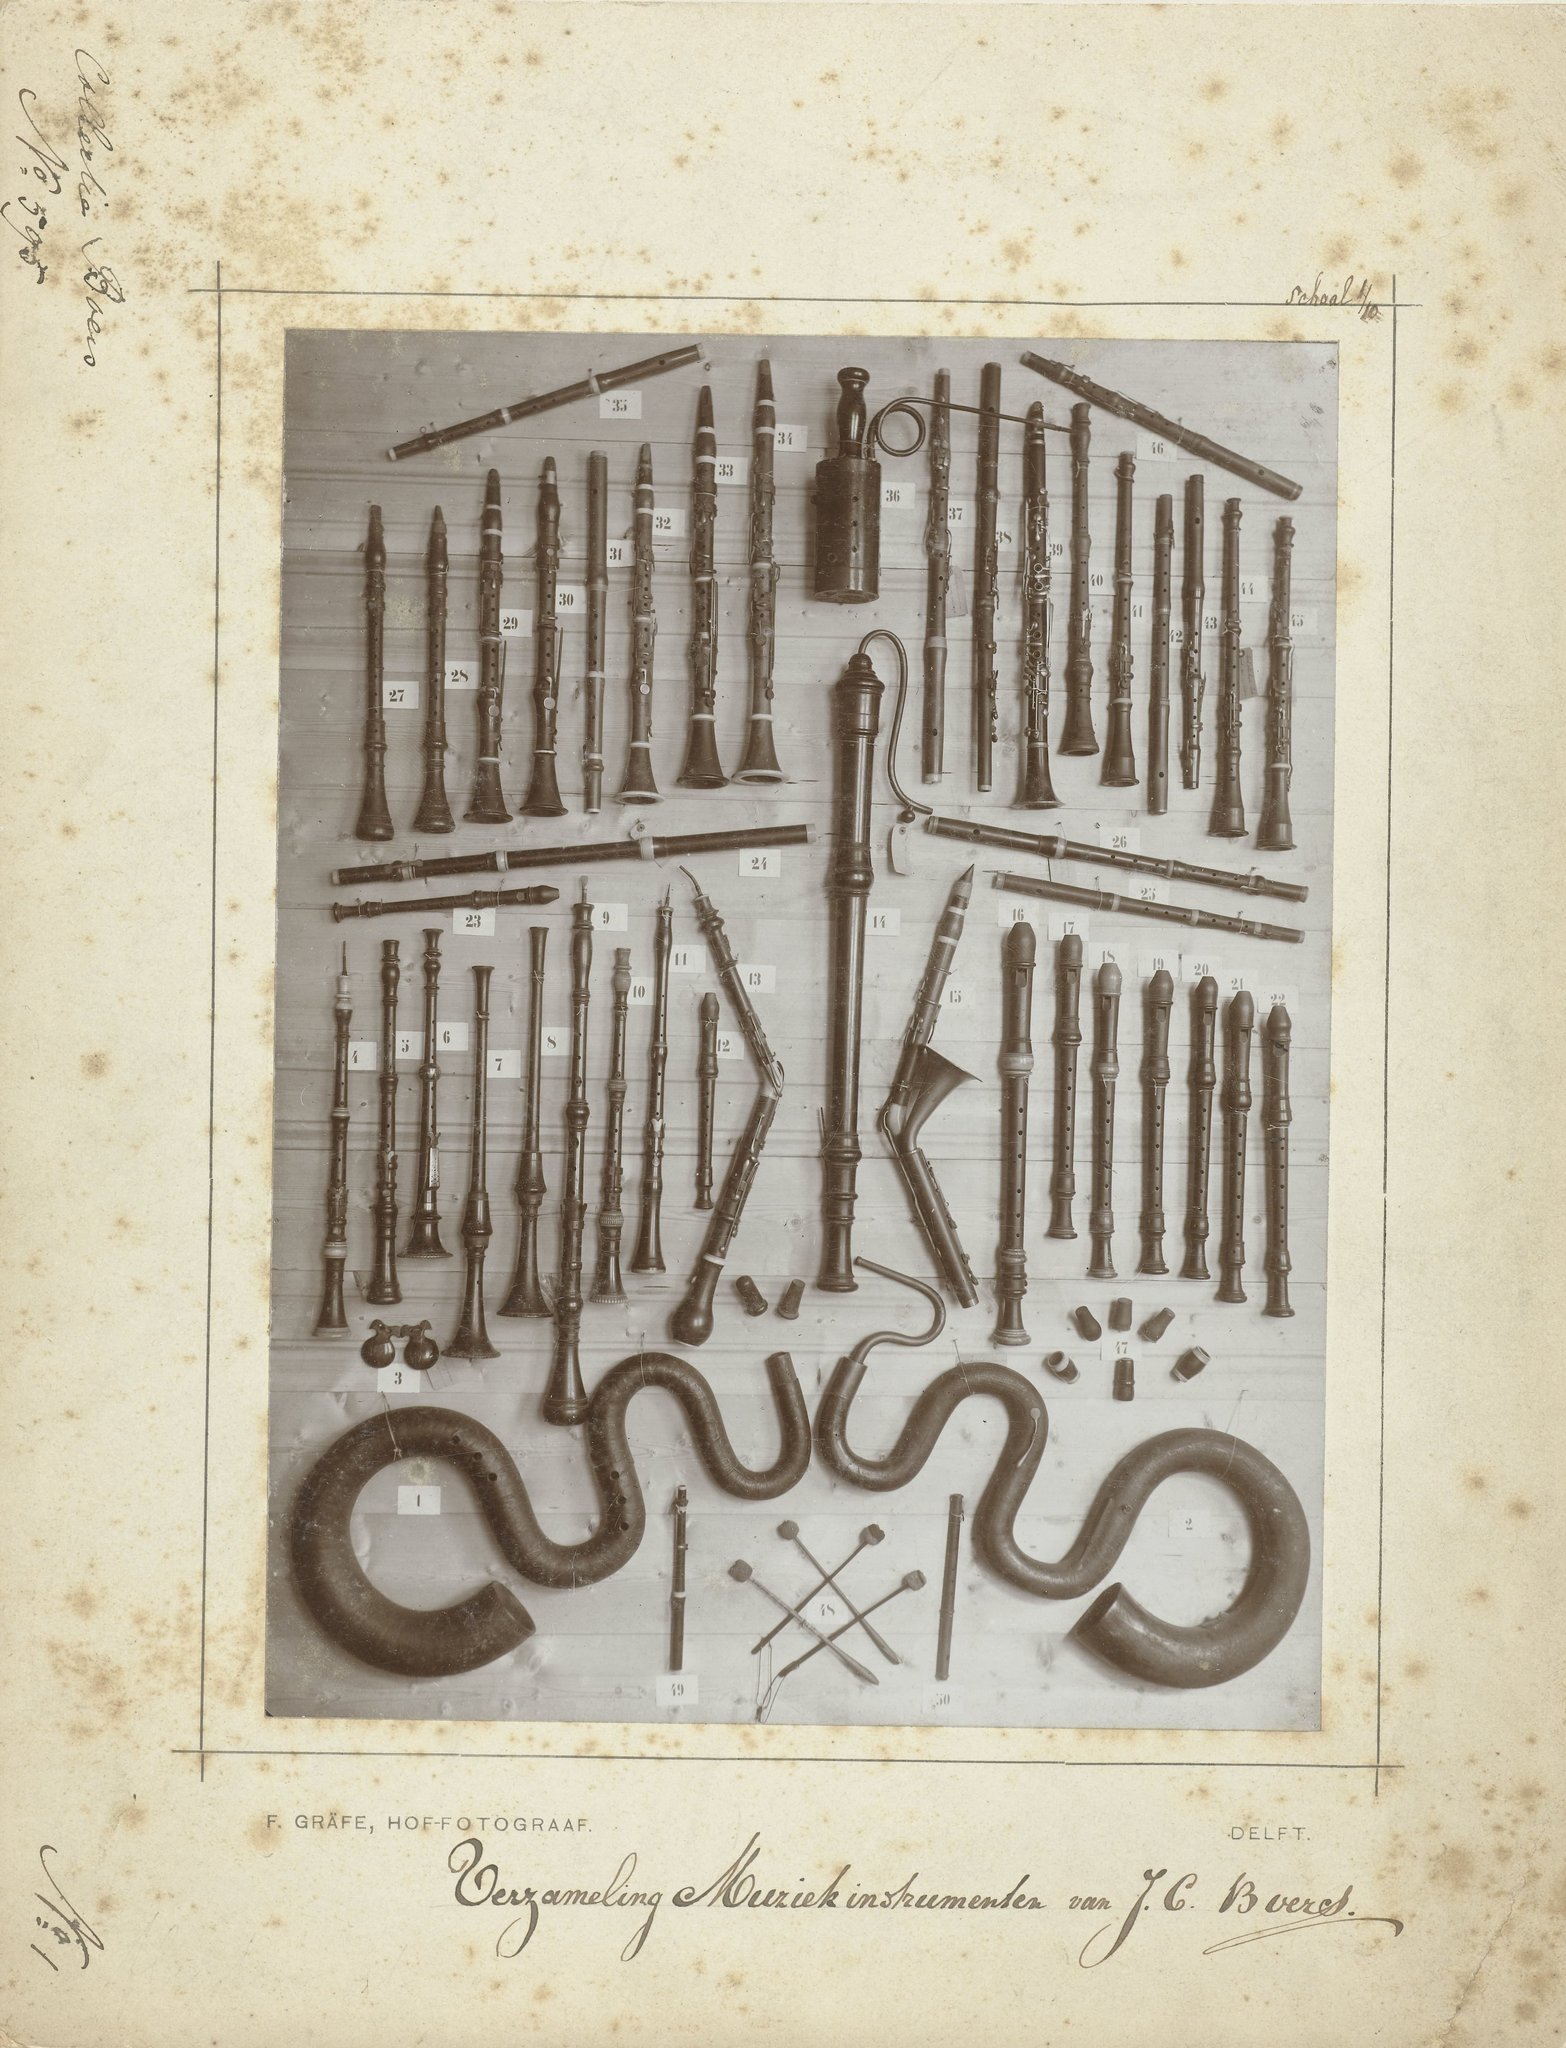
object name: photograph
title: Verzameling muziekinstrumenten uit de collectie van J.C. Boers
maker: frederik christiaan filip gräfe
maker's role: fotograaf, lithograaf, steendrukker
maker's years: 1835-1905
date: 1863-1905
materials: cardboard, paper, photographic support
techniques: collodion silver print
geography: delft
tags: wind instruments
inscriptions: annotation: ‘F. GRÄFE, HOF-FOTOGRAAF. DELFT.’, annotation: ‘Verzameling Muziekinstrumenten van J.C. Boers. / schaal 1/10 / Collectie Boers / No. 595’, annotation: ‘Instrumenten. / Muziekinstrumenten’